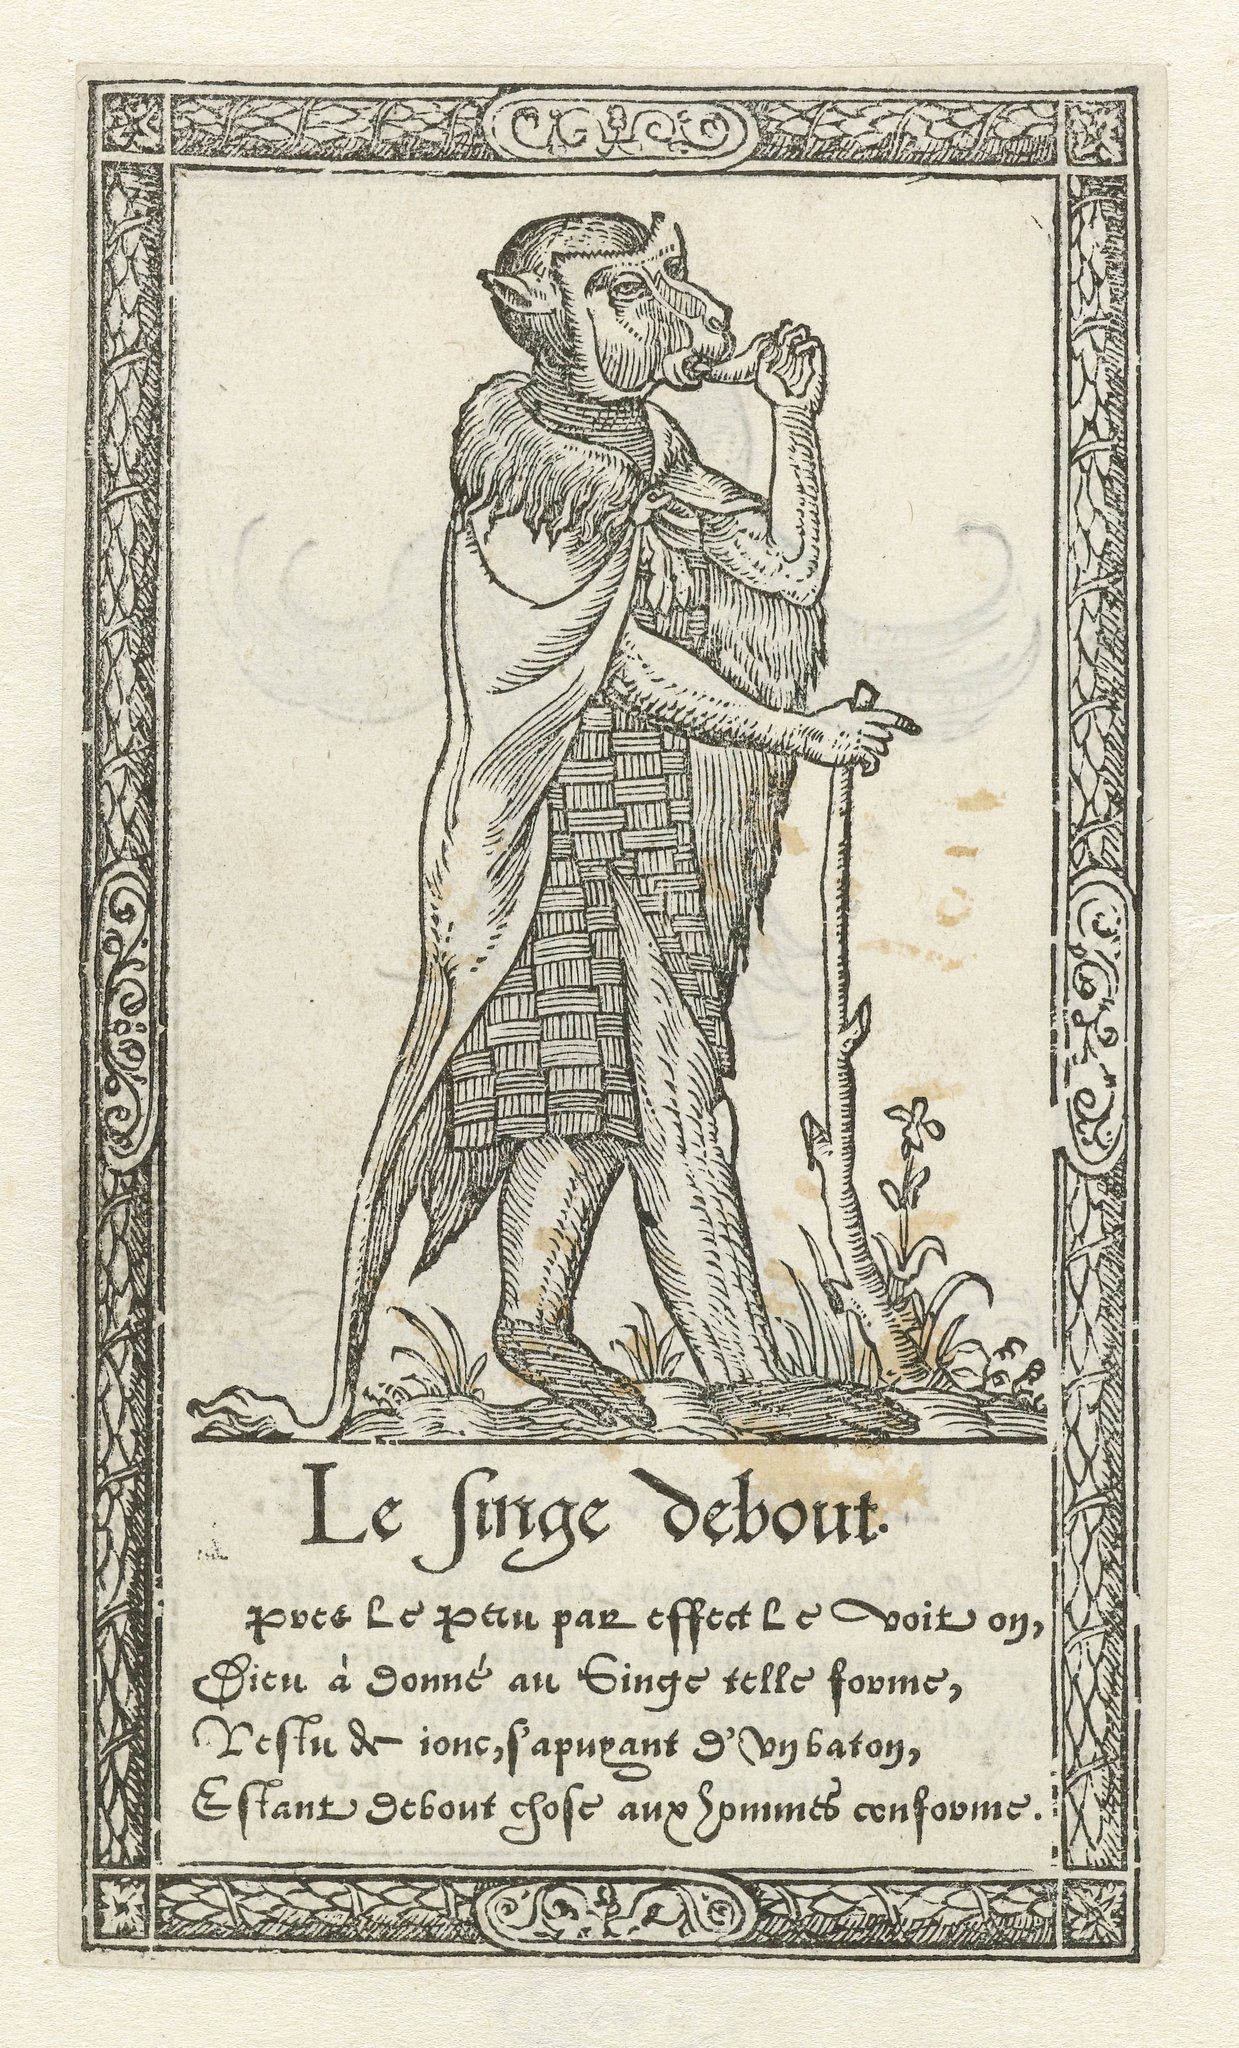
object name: print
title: Serie van verschillende klederdrachten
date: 1562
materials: paper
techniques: woodcut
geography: paris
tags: animals acting as human beings, folk costume, regional costume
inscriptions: collector's mark: Lugt 2228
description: Dit is prent 52 uit een serie van 121. Binnen deze serie zijn er prenten gemaakt naar voorbeelden van Jean-François de Roberval en Enea Vico, onbekend welke precies.